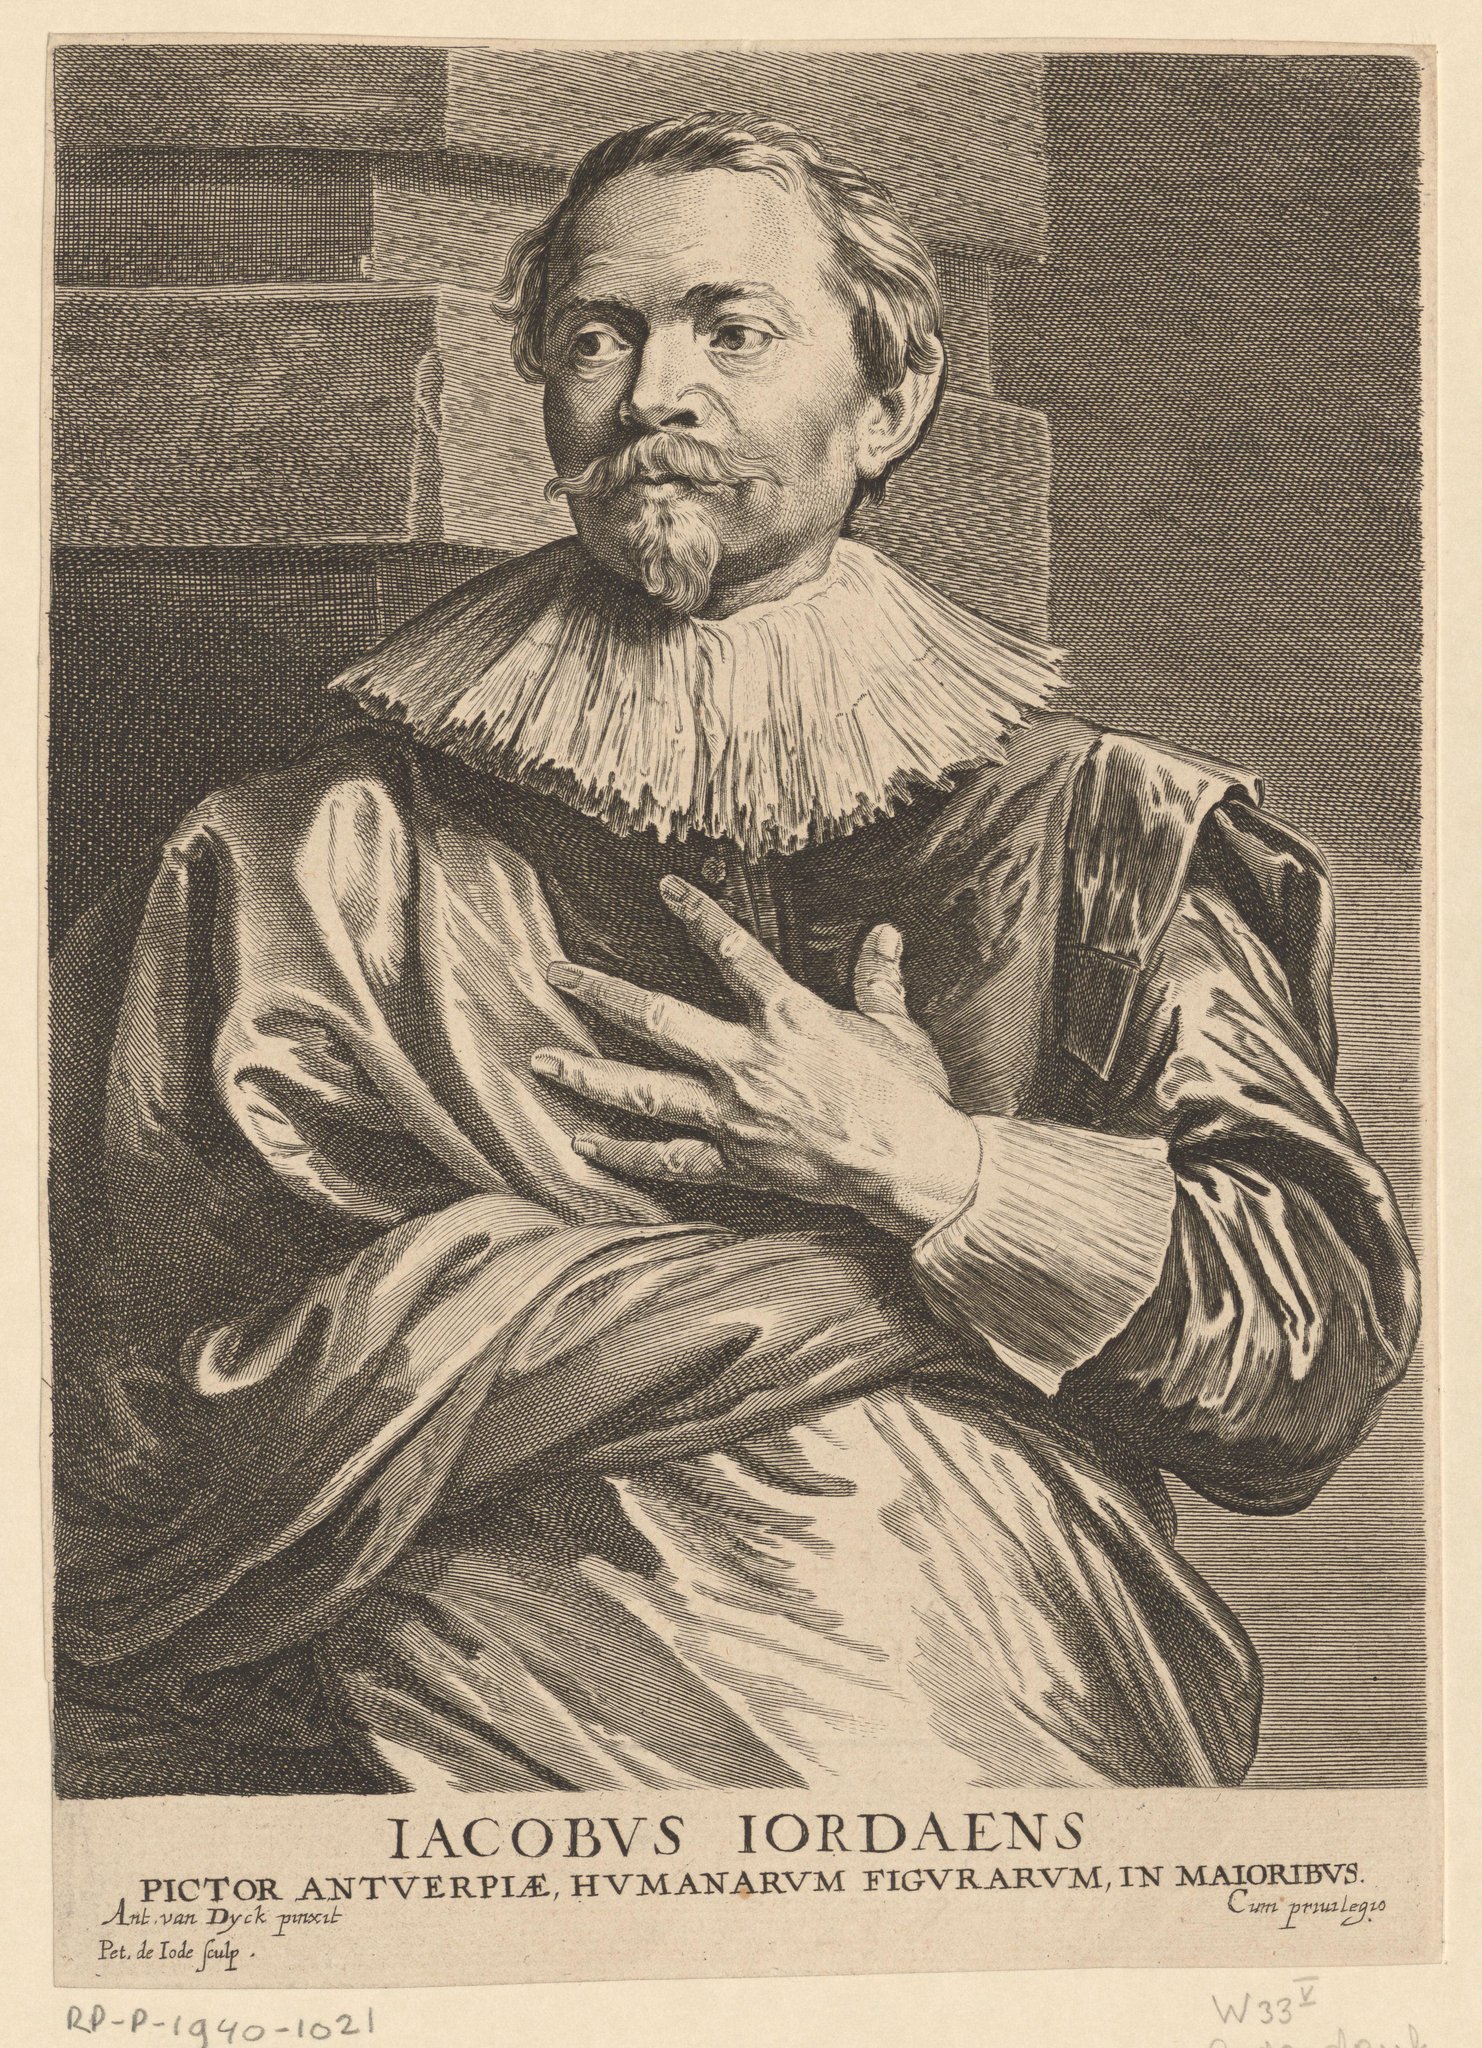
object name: print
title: Portret van Jacques Jordaens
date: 1616-1674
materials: paper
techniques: engraving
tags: antwerp, painter, print maker, draughtsman, designer, jacques jordaens, historical persons, portrait, self-portrait of painter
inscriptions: collector's mark: Lugt 2760, collector's mark: Lugt 2166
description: Deze prent betreft een latere druk. De datering is gebaseerd op de werkzame periode van de prentmaker, maar het is onduidelijk wanneer de afdruk van deze prent precies is gemaakt, waarschijnlijk veel later.